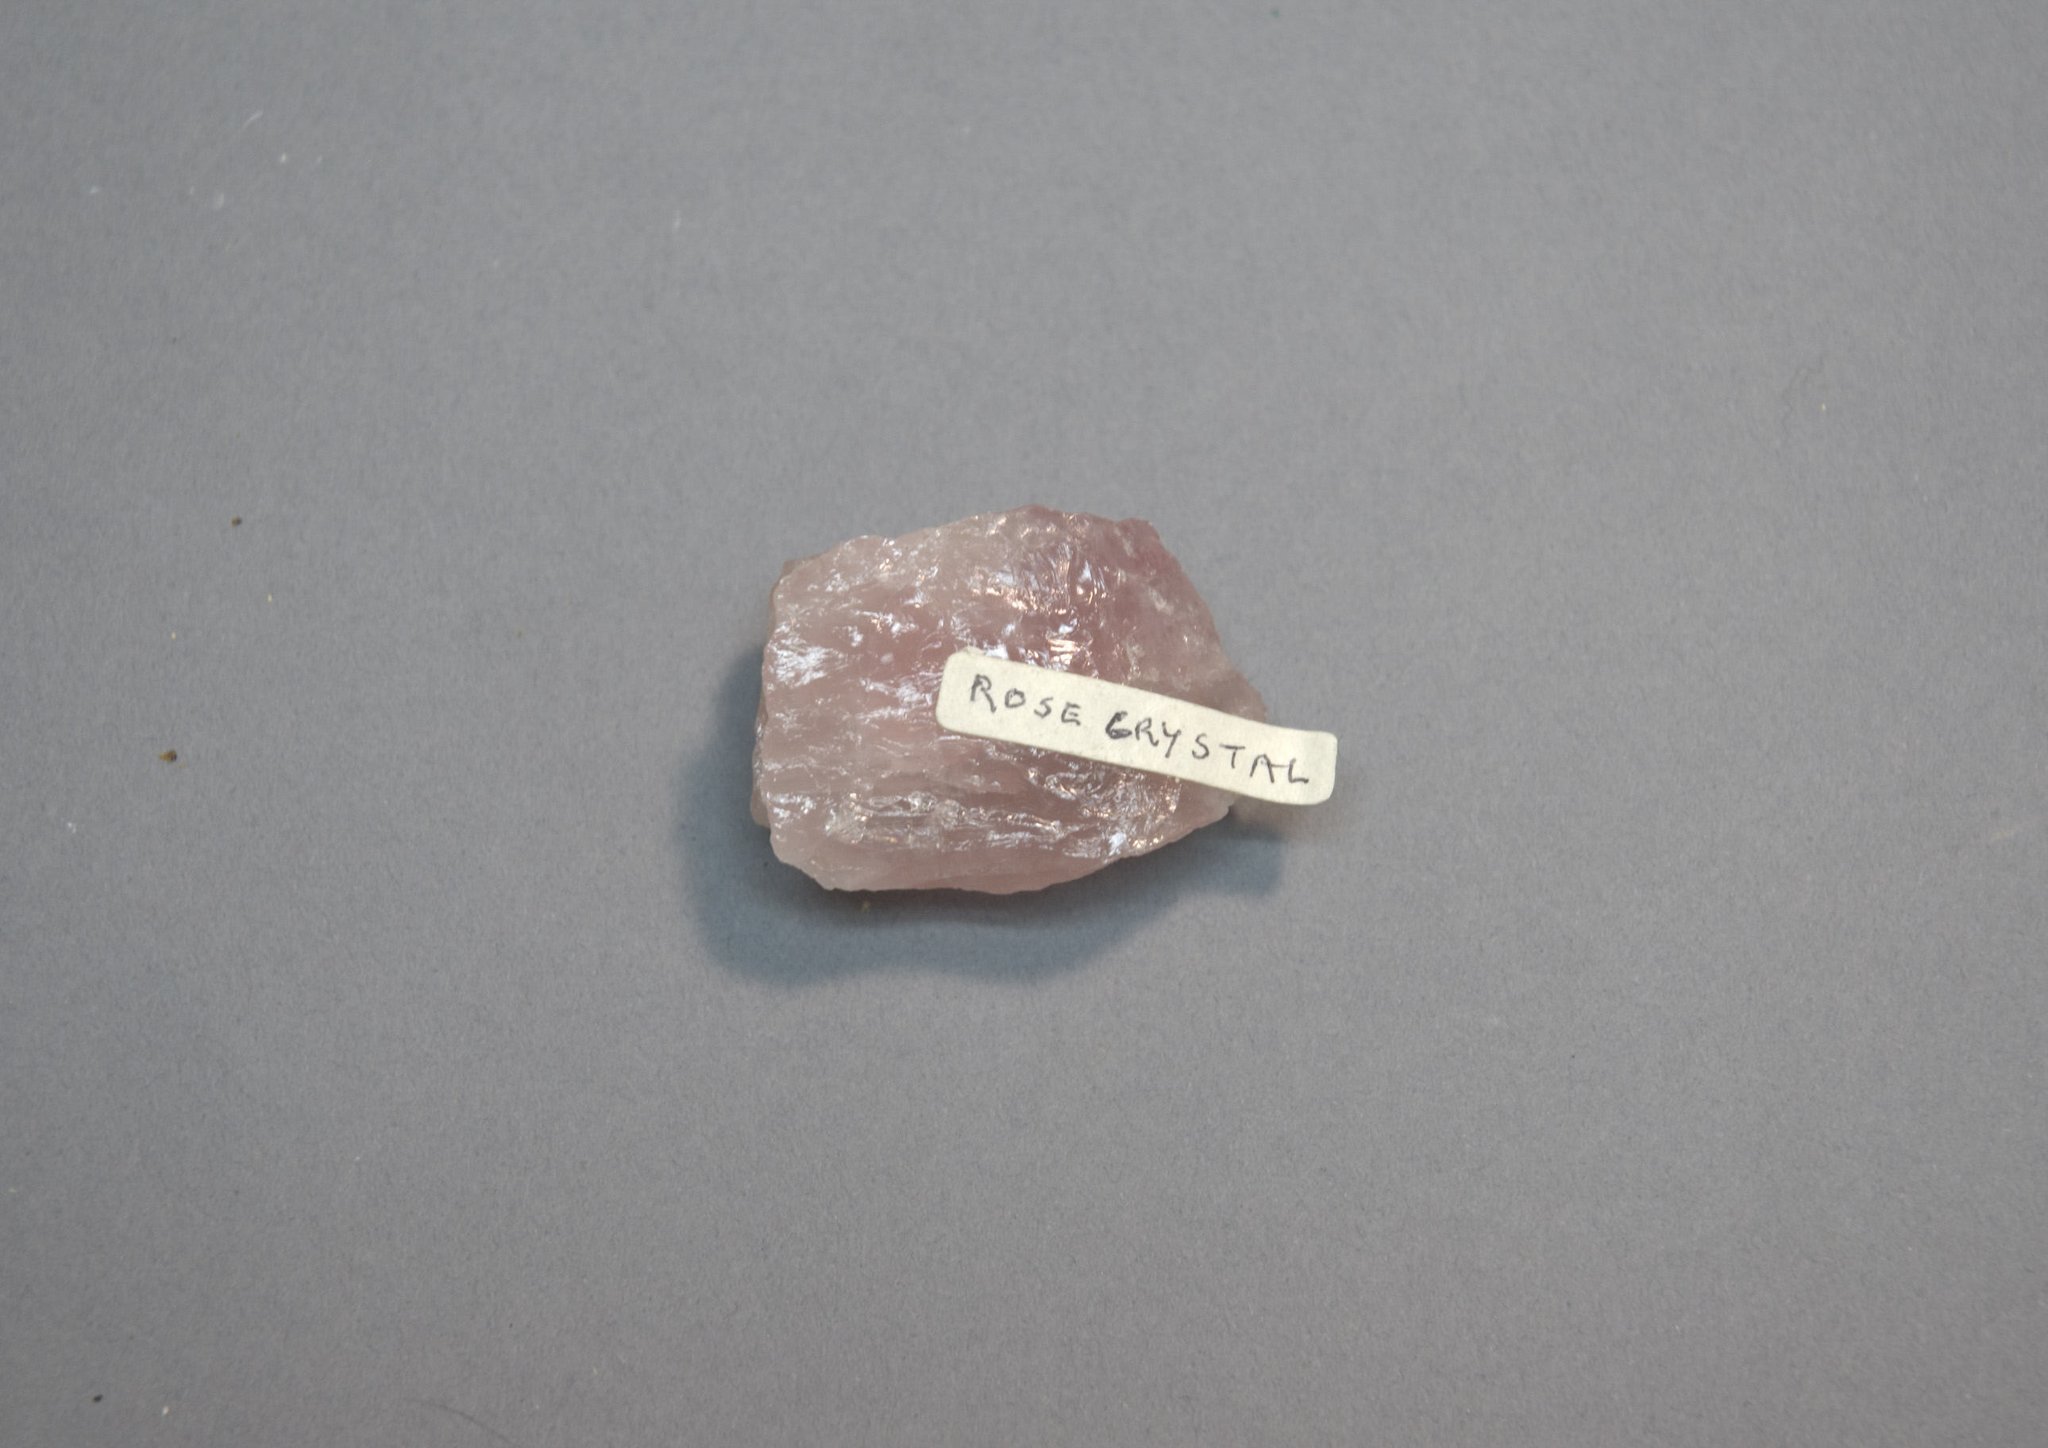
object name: jade carving material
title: Sample of Rose Crystal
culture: chinese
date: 1901-2000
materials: crystal